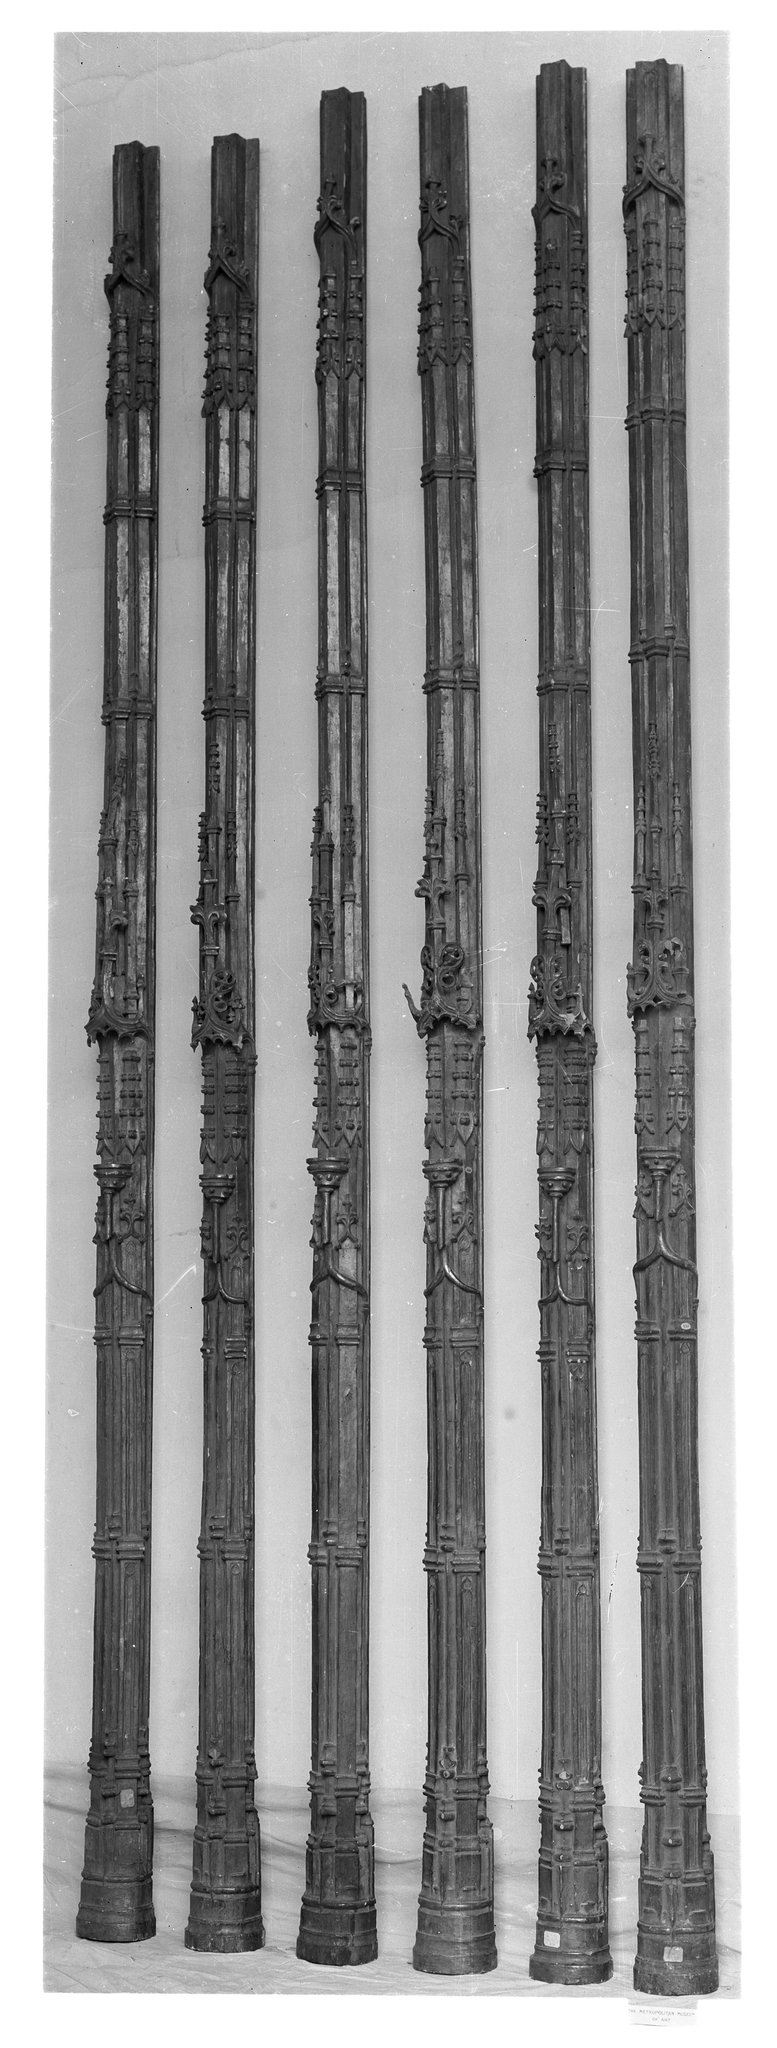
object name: pilaster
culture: french or italian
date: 1501-1600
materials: gold leaf, wood